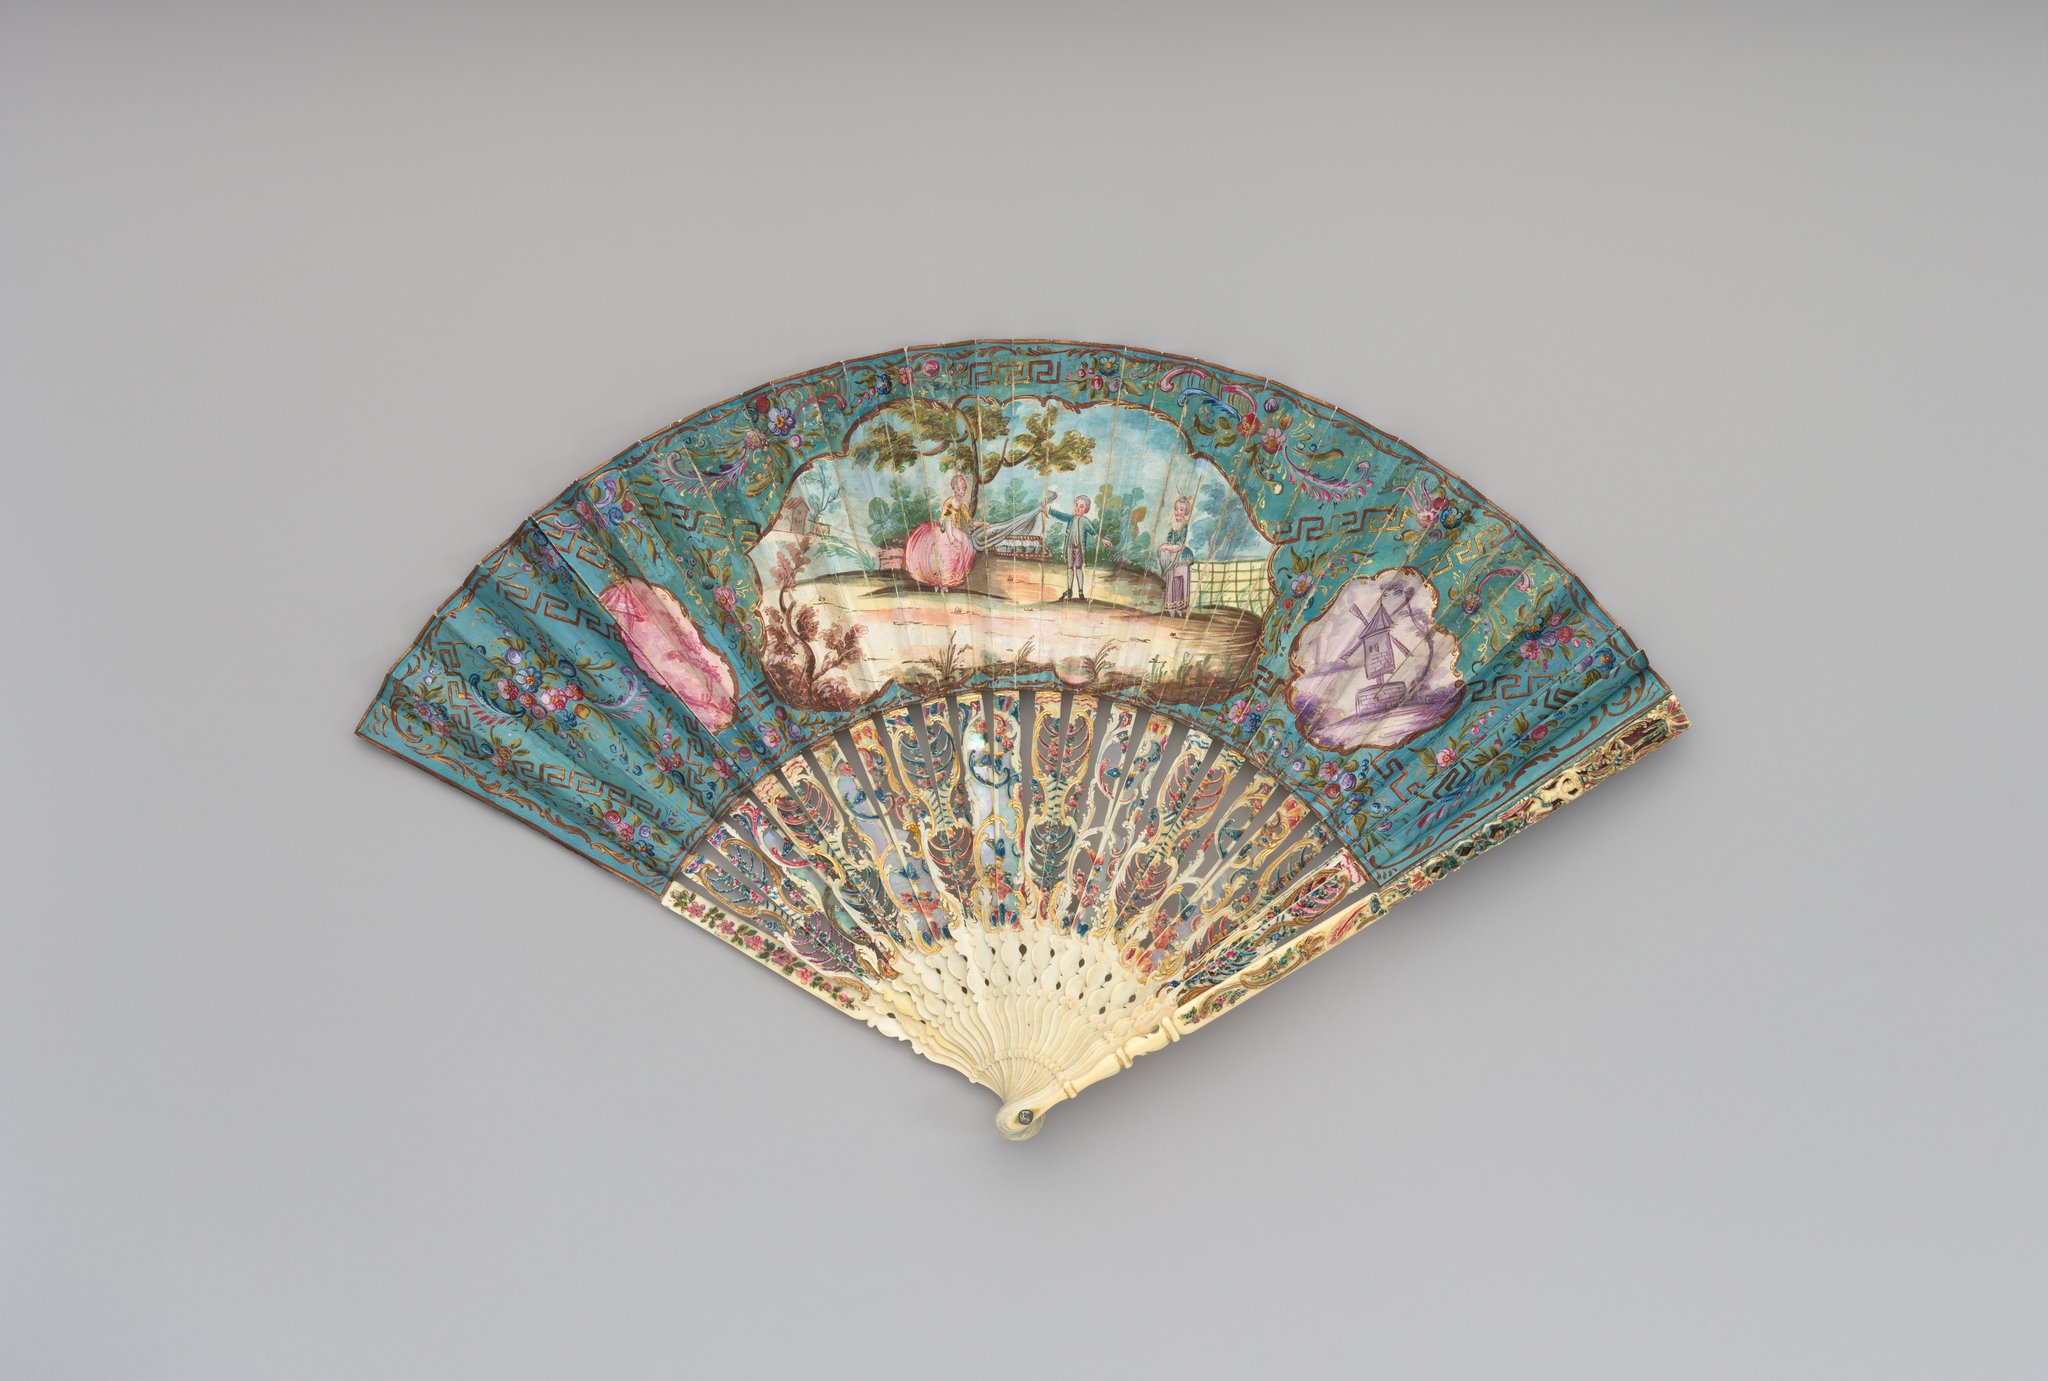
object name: fan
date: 1751-1775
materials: ivory, mother of pearl, paper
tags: windmills,men,women